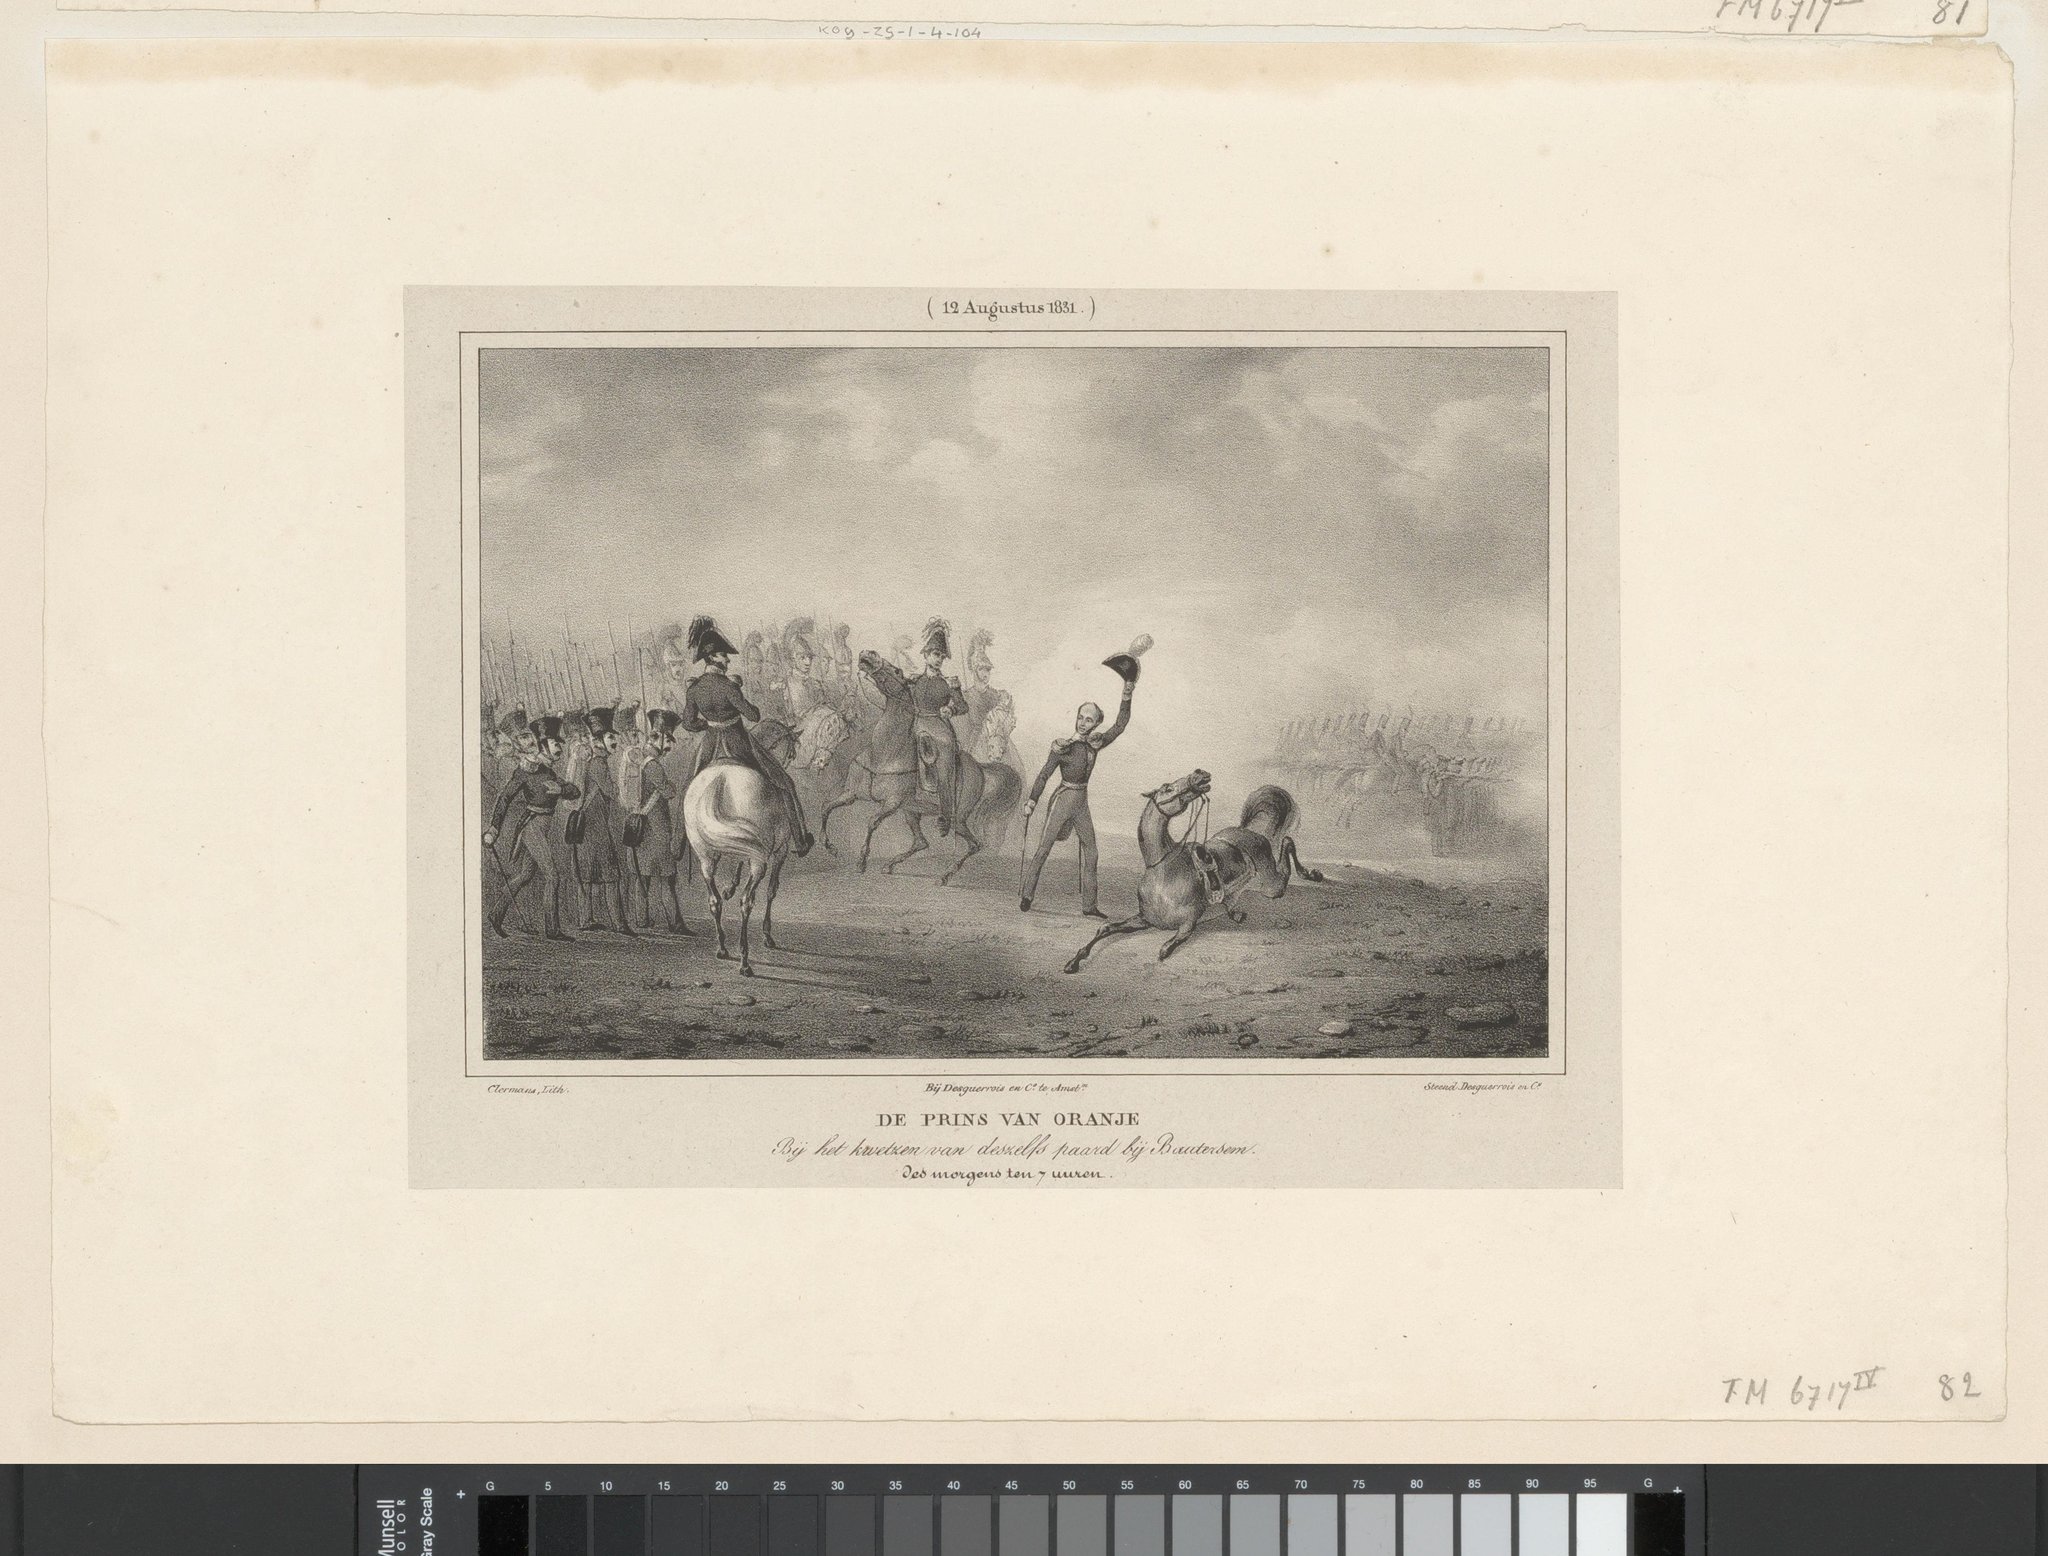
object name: print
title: De Prins van Oranje bij het kwetzen van deszelfs paard bij Bautersem, des morgens ten 7 uuren / (12 Augustus 1831)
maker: j.b. clermans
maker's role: print maker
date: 1831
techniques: printmaking, lithograph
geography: netherlands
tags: the hague, william ii of the netherlands, fighting horses, battle (+ land forces)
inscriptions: collector's mark, collector's mark: Lugt 1641